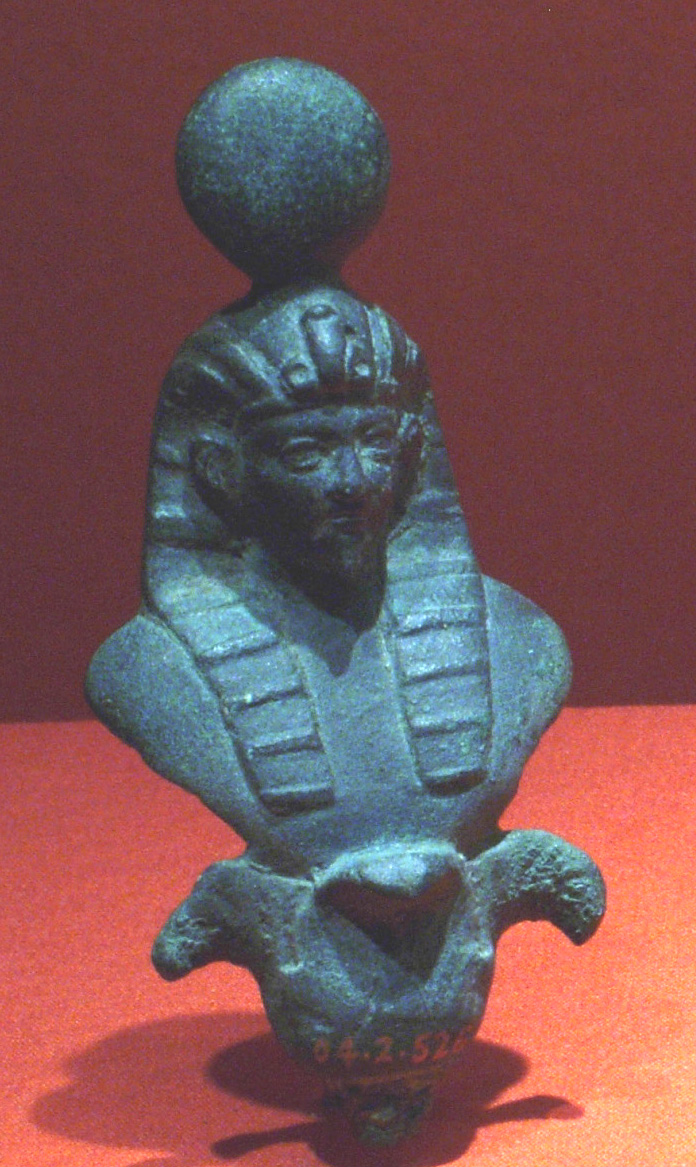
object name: finial, osiris, nemes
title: Finial with nemes and crowned figure, probably Osiris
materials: bronze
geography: egypt